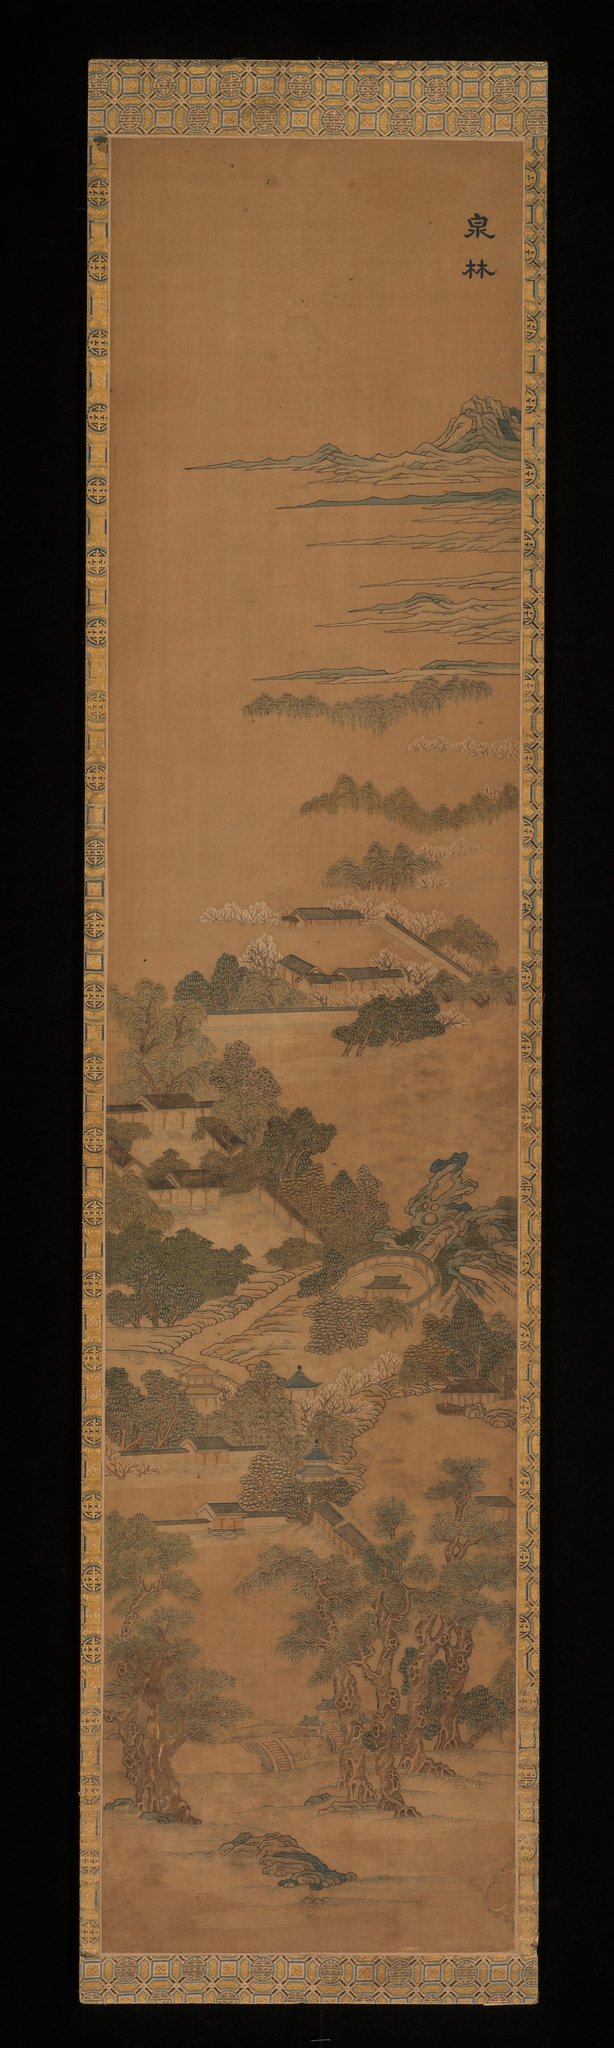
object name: kesi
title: Scenic Sites in the Qianlong Emperor’s Southern Inspection Tour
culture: chinese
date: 1801-1900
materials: ink, silk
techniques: tapestry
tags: landscapes